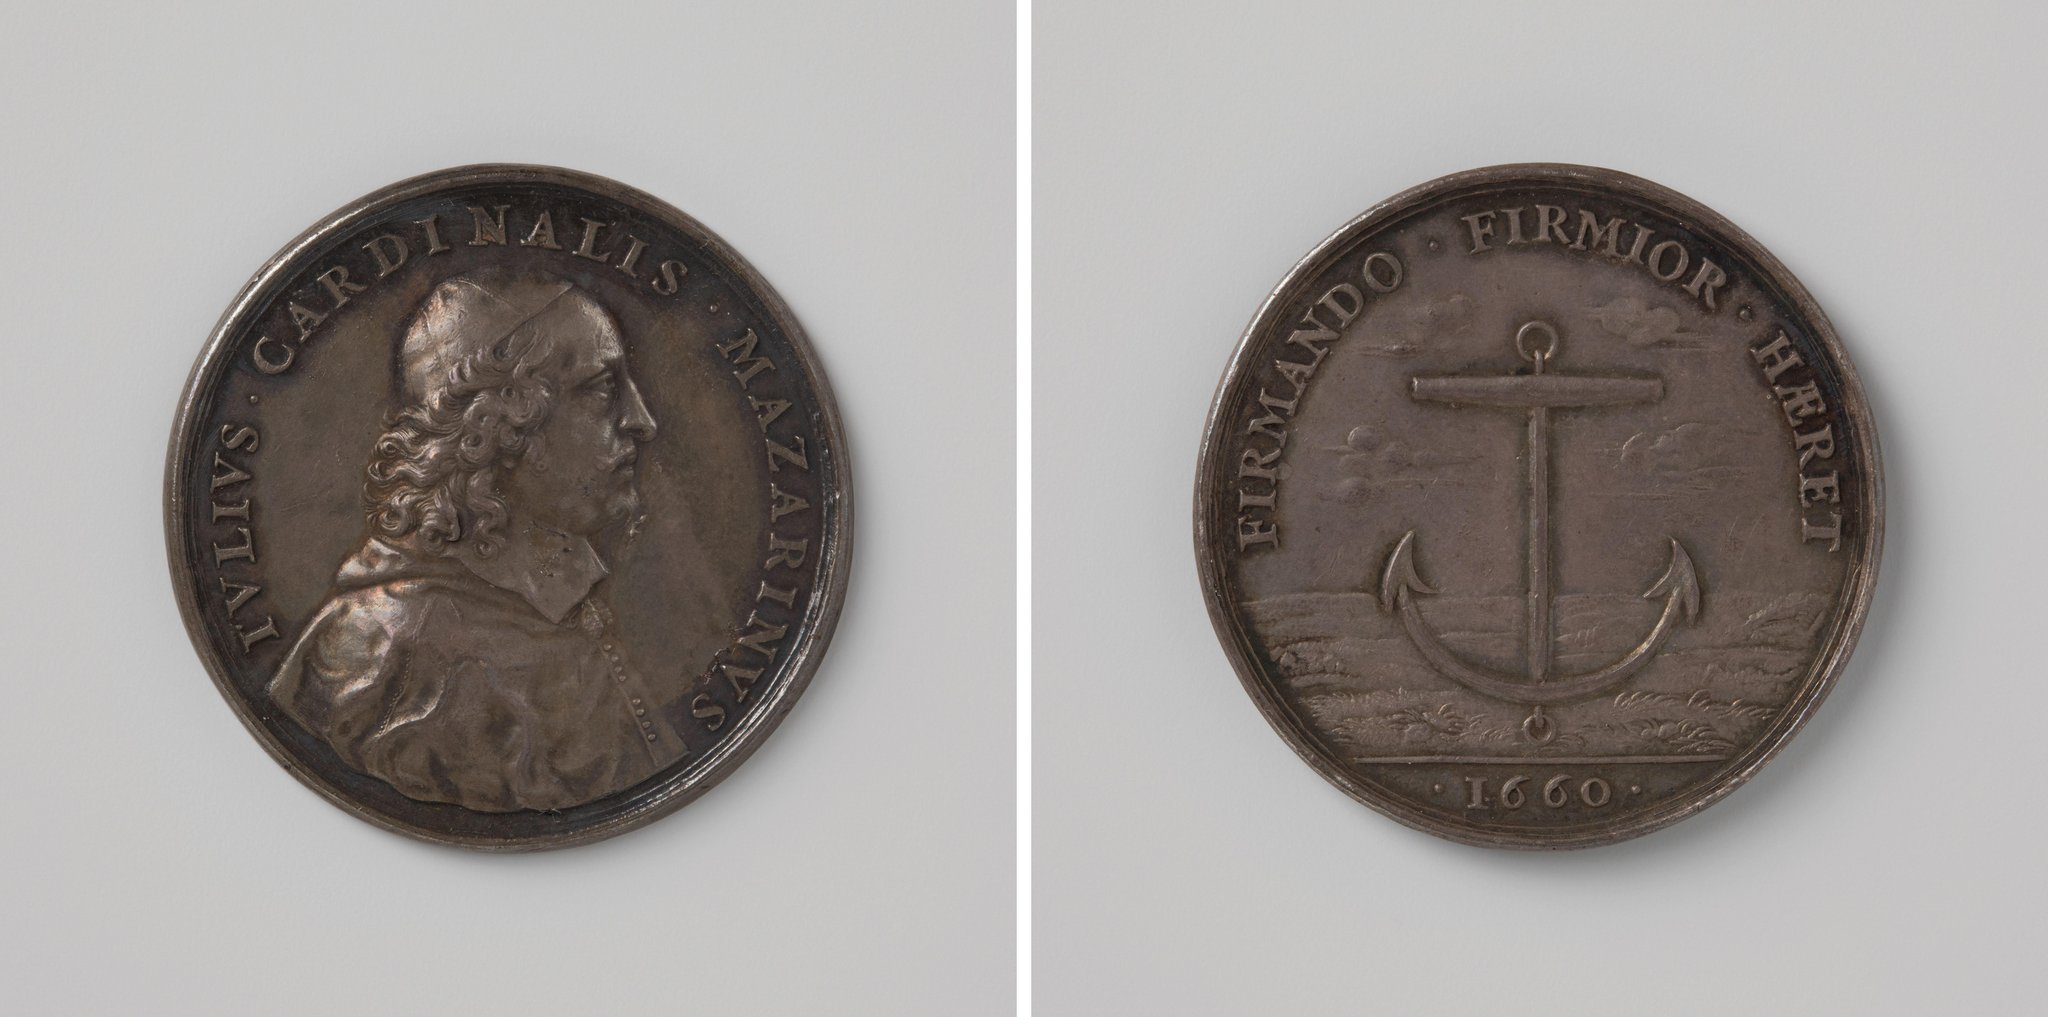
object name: honorary medal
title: Vrede van de Pyreneen, ter ere van kardinaal Mazarin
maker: jean warin (ii)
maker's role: medailleur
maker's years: 1596-1672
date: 1660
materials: silver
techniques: striking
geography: paris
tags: france, spain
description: Zilveren penning. Voorzijde: borststuk man binnen omschrift. Keerzijde: scheepsanker binnen omschrift.